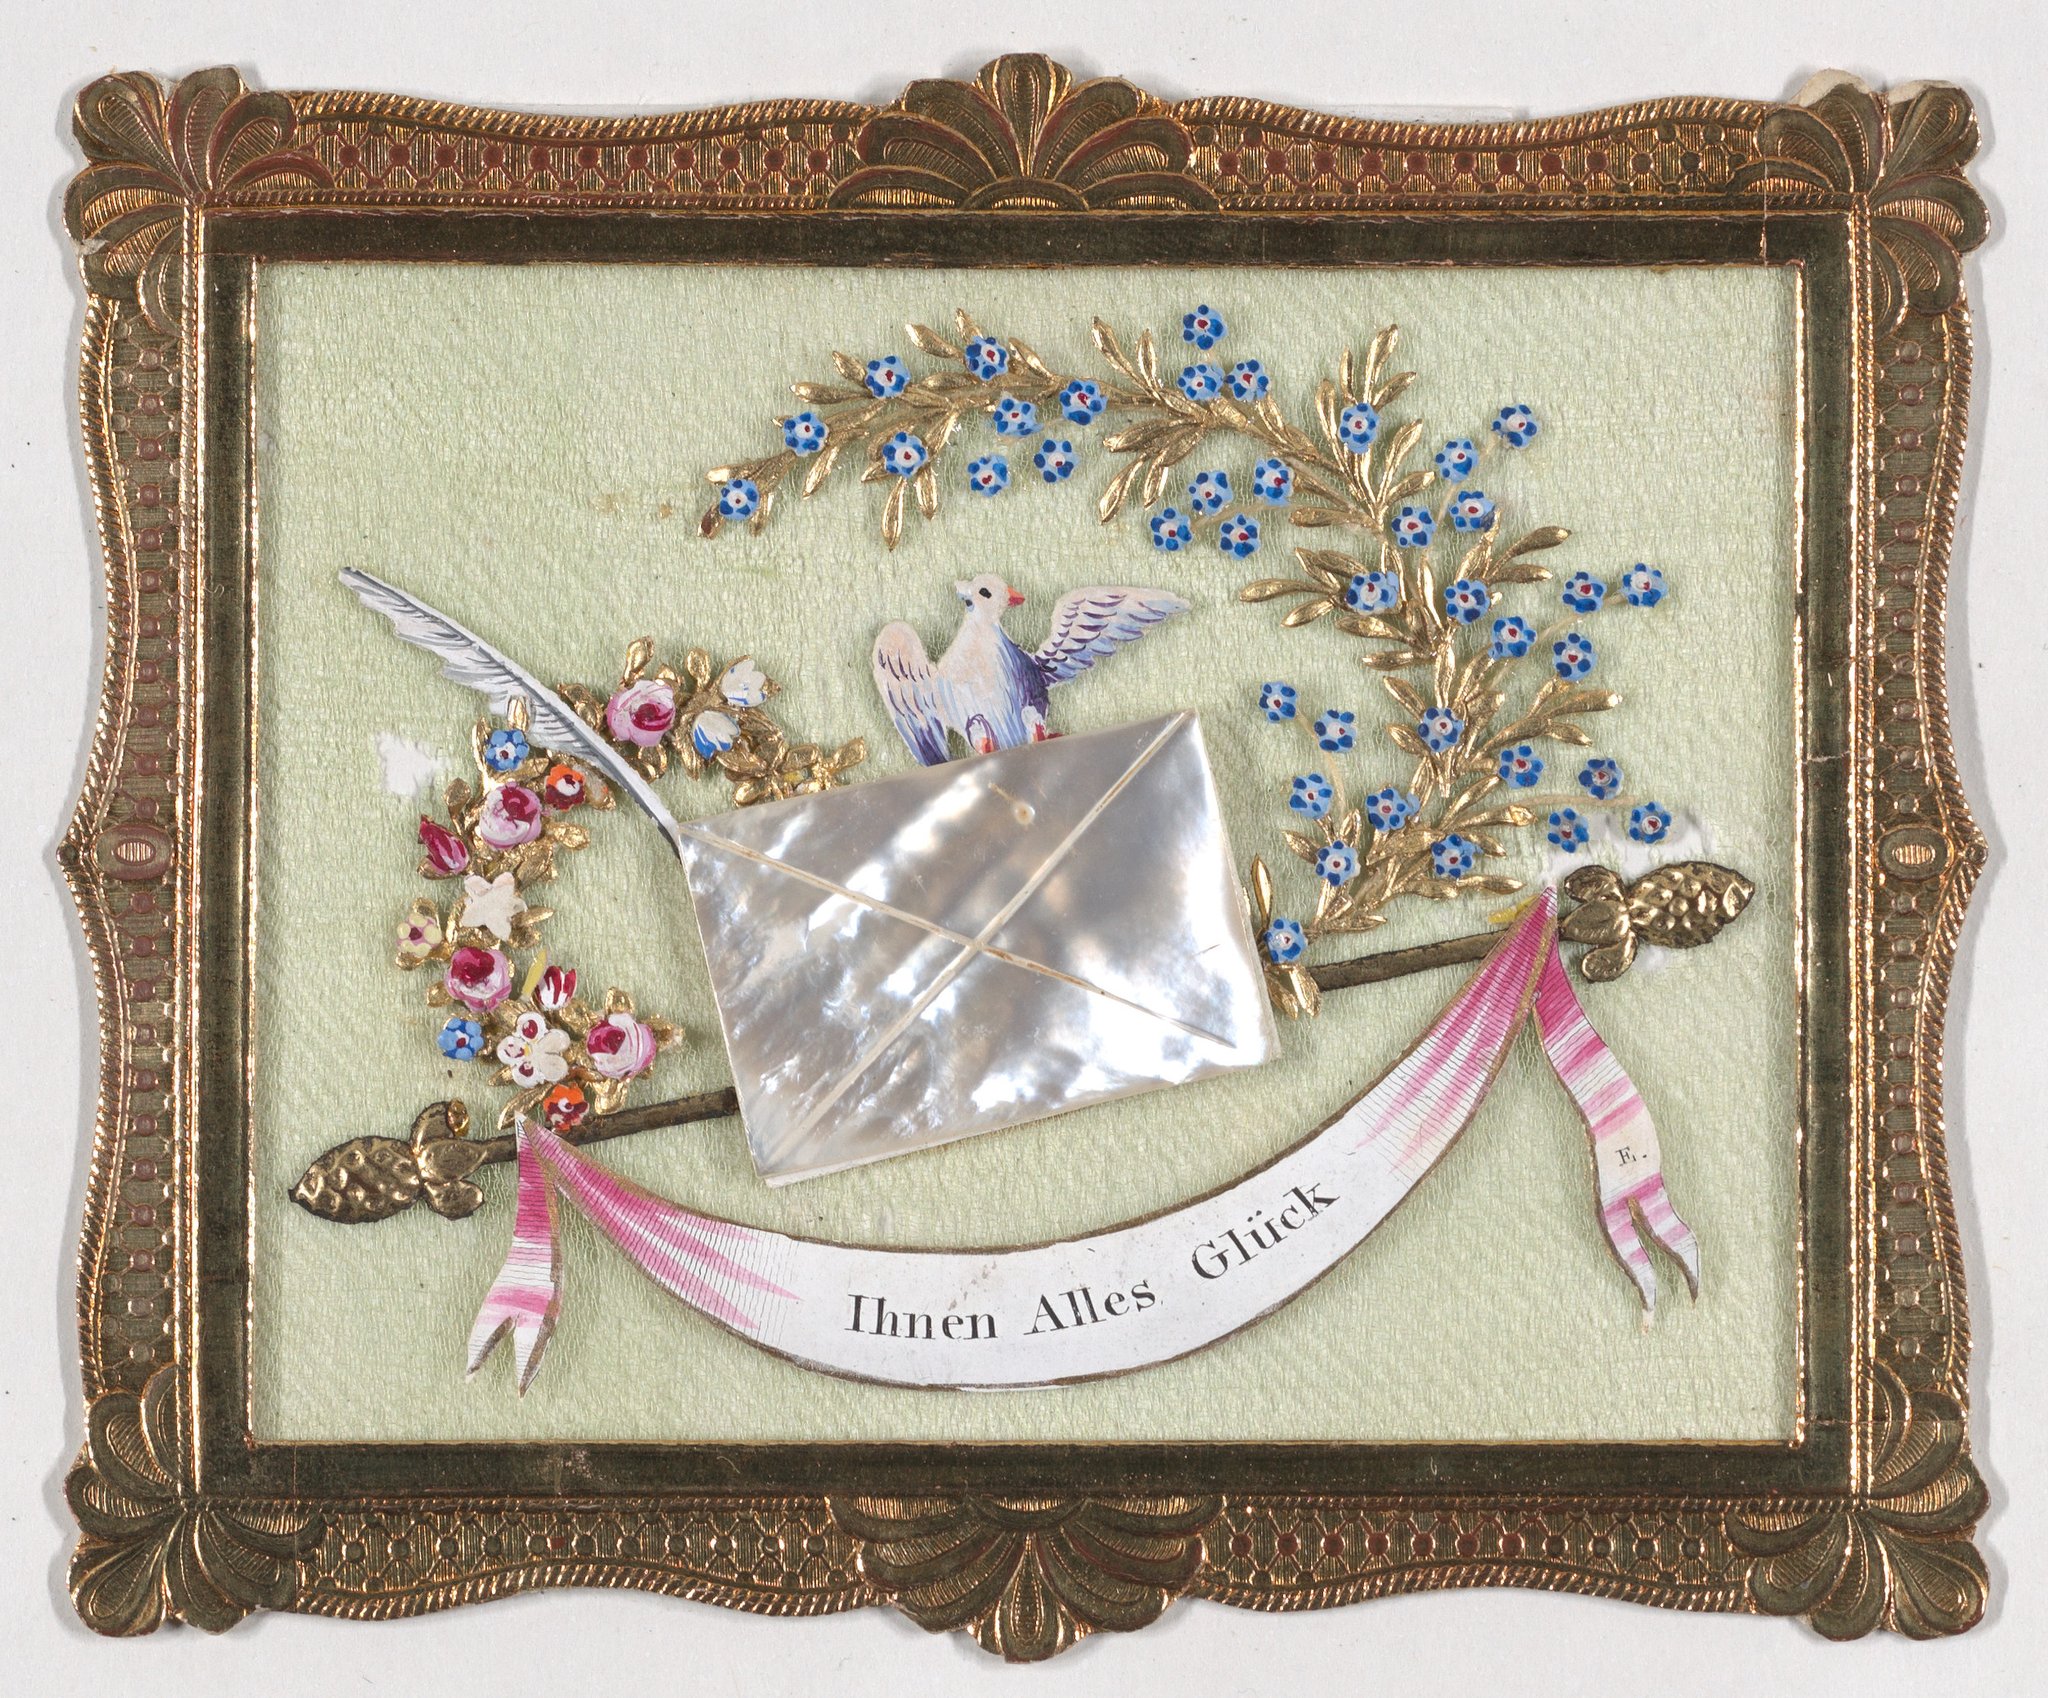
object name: greeting card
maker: johannes endletzberger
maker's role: artist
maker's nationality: austrian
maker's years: 1782-1850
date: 1810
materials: foil, gouache, mother of pearl, paint, paper, silk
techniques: carving, embossing, painting